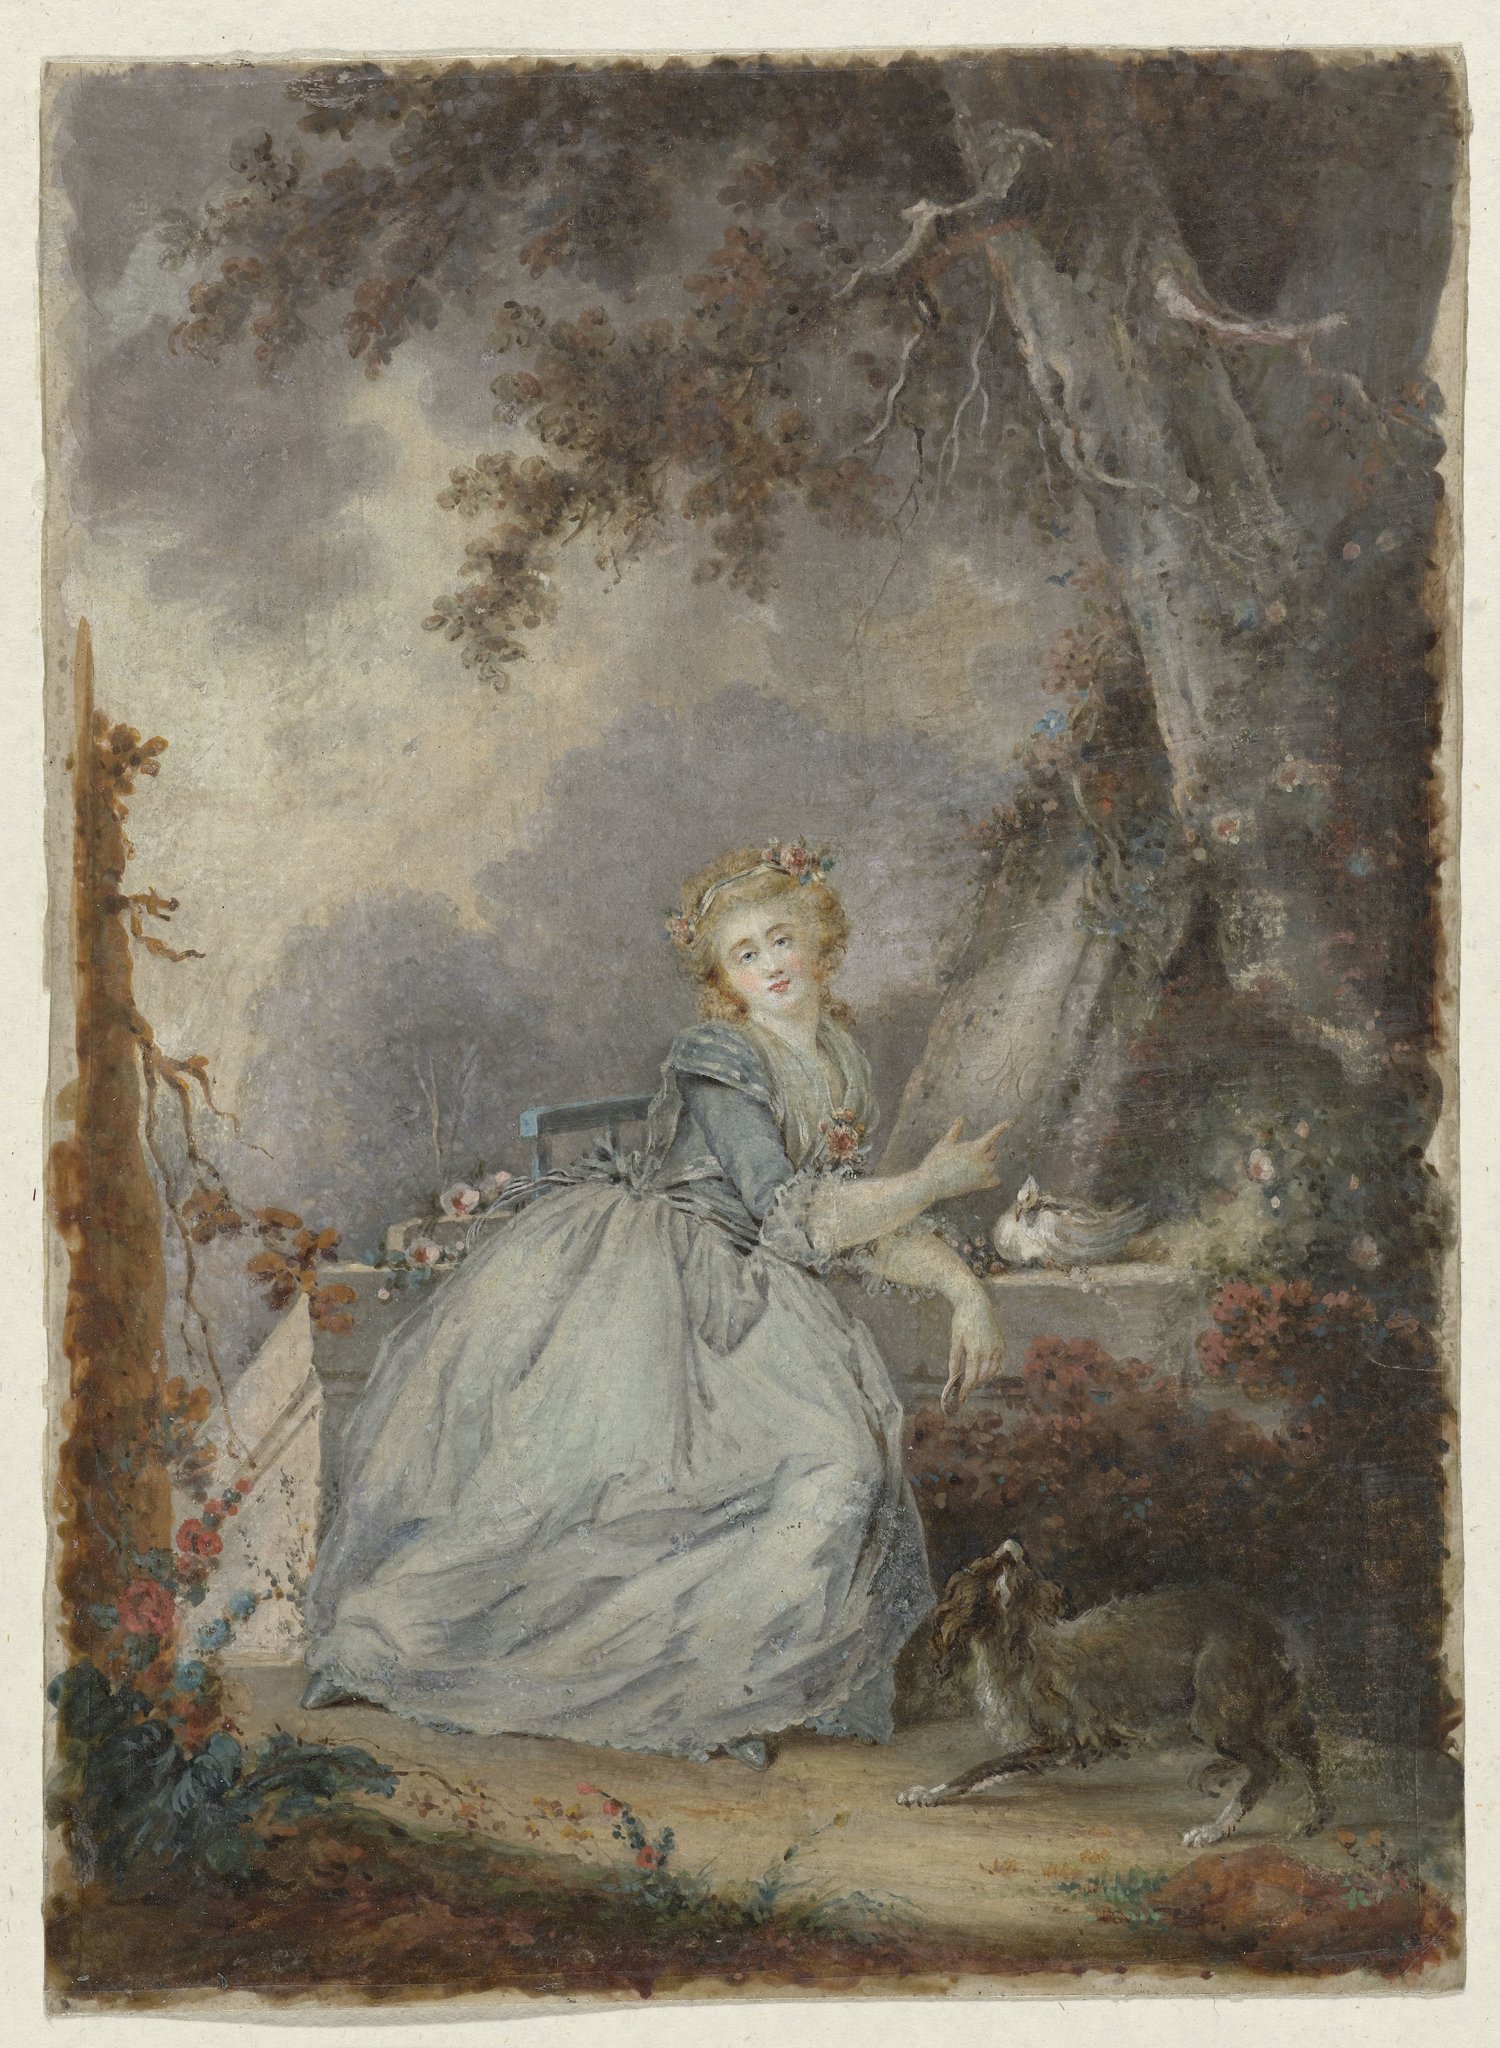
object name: drawing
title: Jonge dame bij een stenen balustrade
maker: jean frédéric schall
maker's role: draughtsman, painter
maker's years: 1752-1825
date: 1762-1825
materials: paint, paper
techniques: brush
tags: adolescent, young woman, maiden, carving heart and initials in an object, e.g. a tree trunk, couple of lovers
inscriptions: collector's mark, verso, on the mount, lower centre: Lugt 2228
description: Pendant van "Jongeman knielend bij liefdesaltaar" (inventarisnummer RP-T-1953-210A).